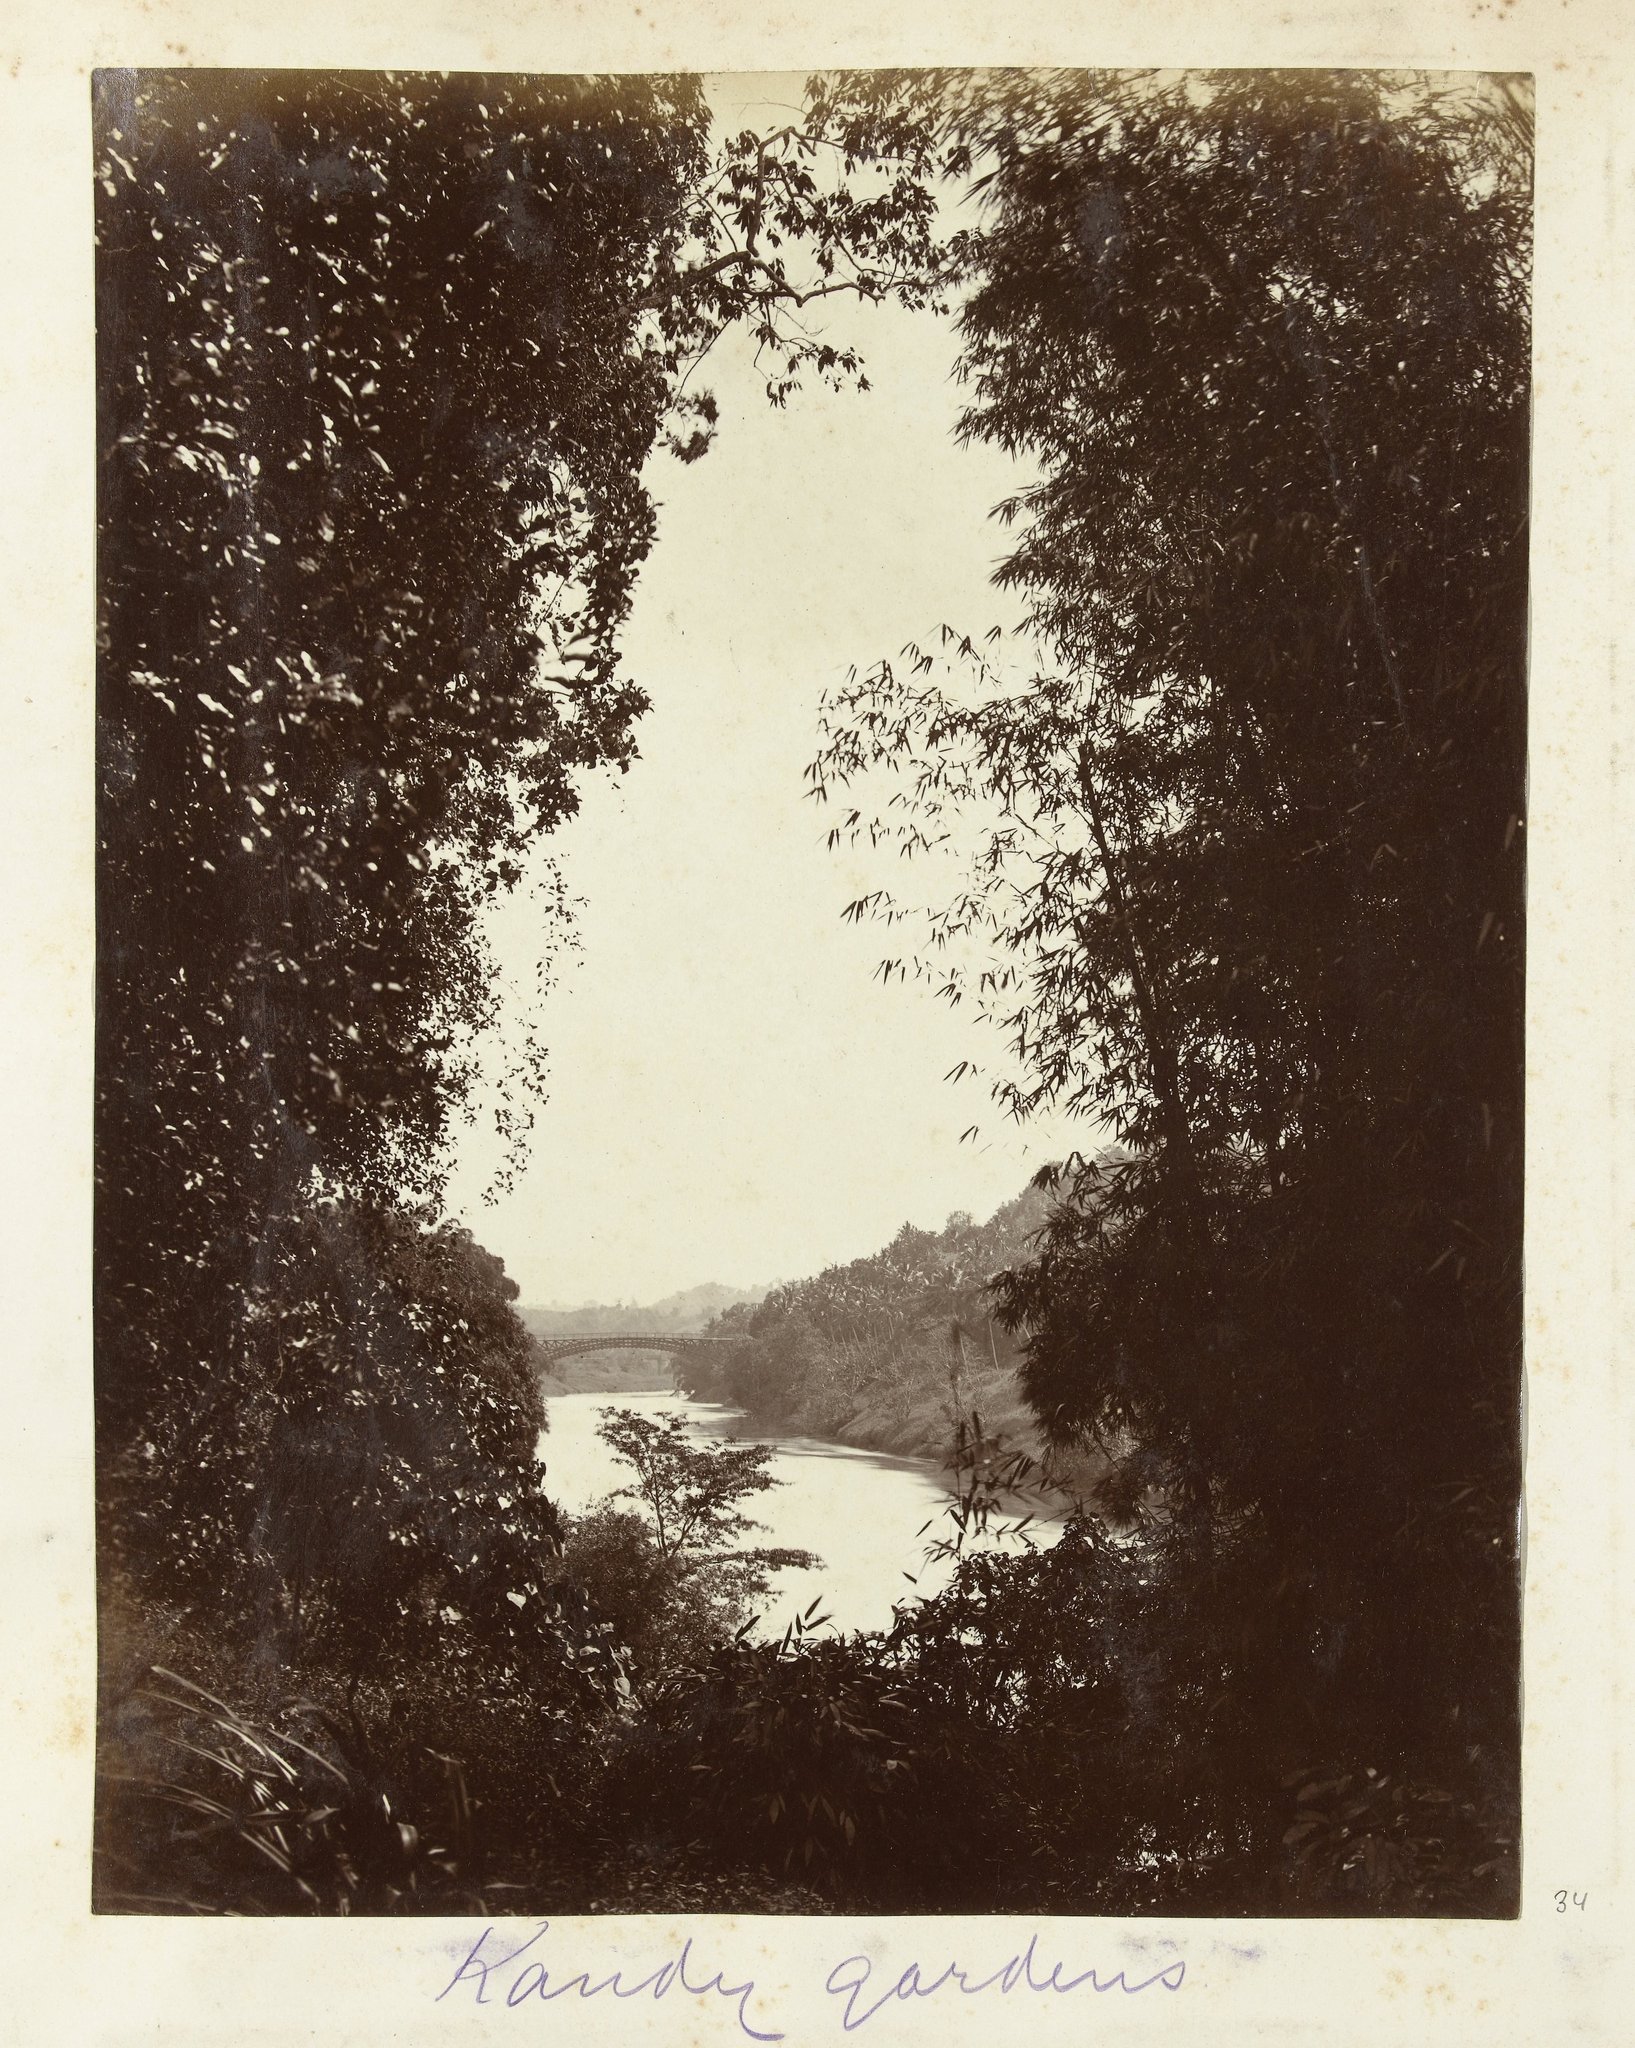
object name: photograph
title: Zicht over de rivier en de botanische tuinen van peradinya in Kandy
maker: Anonymous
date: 1890-1910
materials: cardboard, paper, photographic support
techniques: gelatin silver print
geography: netherlands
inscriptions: caption: ‘Kandy gardens’